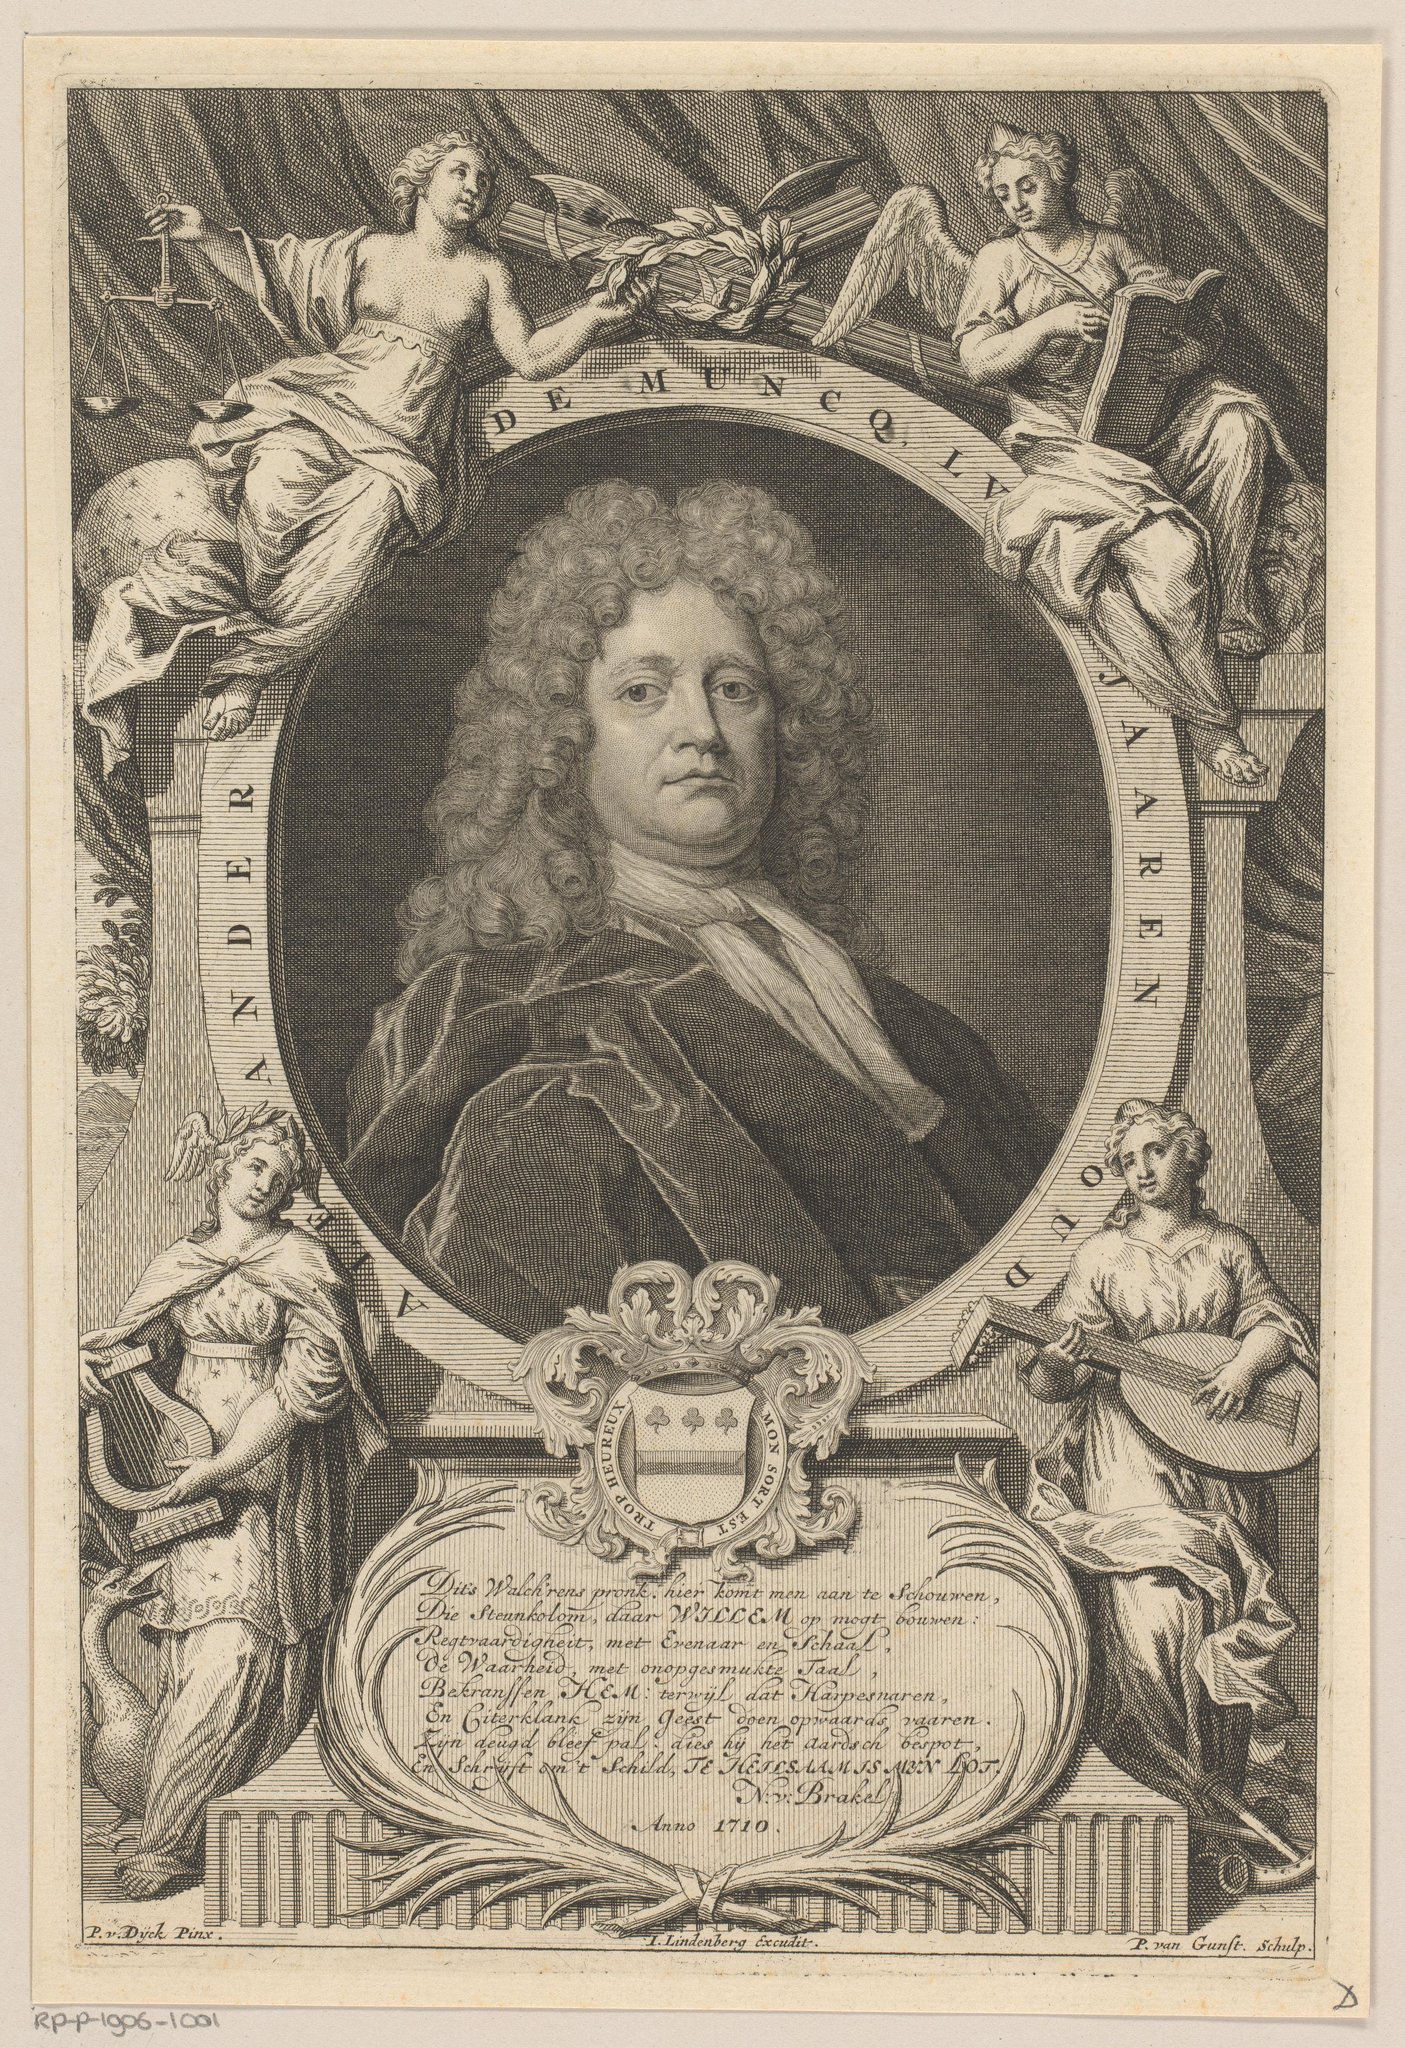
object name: print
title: Portret van Alexander de Muncq op 55-jarige leeftijd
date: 1710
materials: paper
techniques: engraving, etching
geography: amsterdam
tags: making music; musician with instrument, historical persons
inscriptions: collector's mark: Lugt 2228